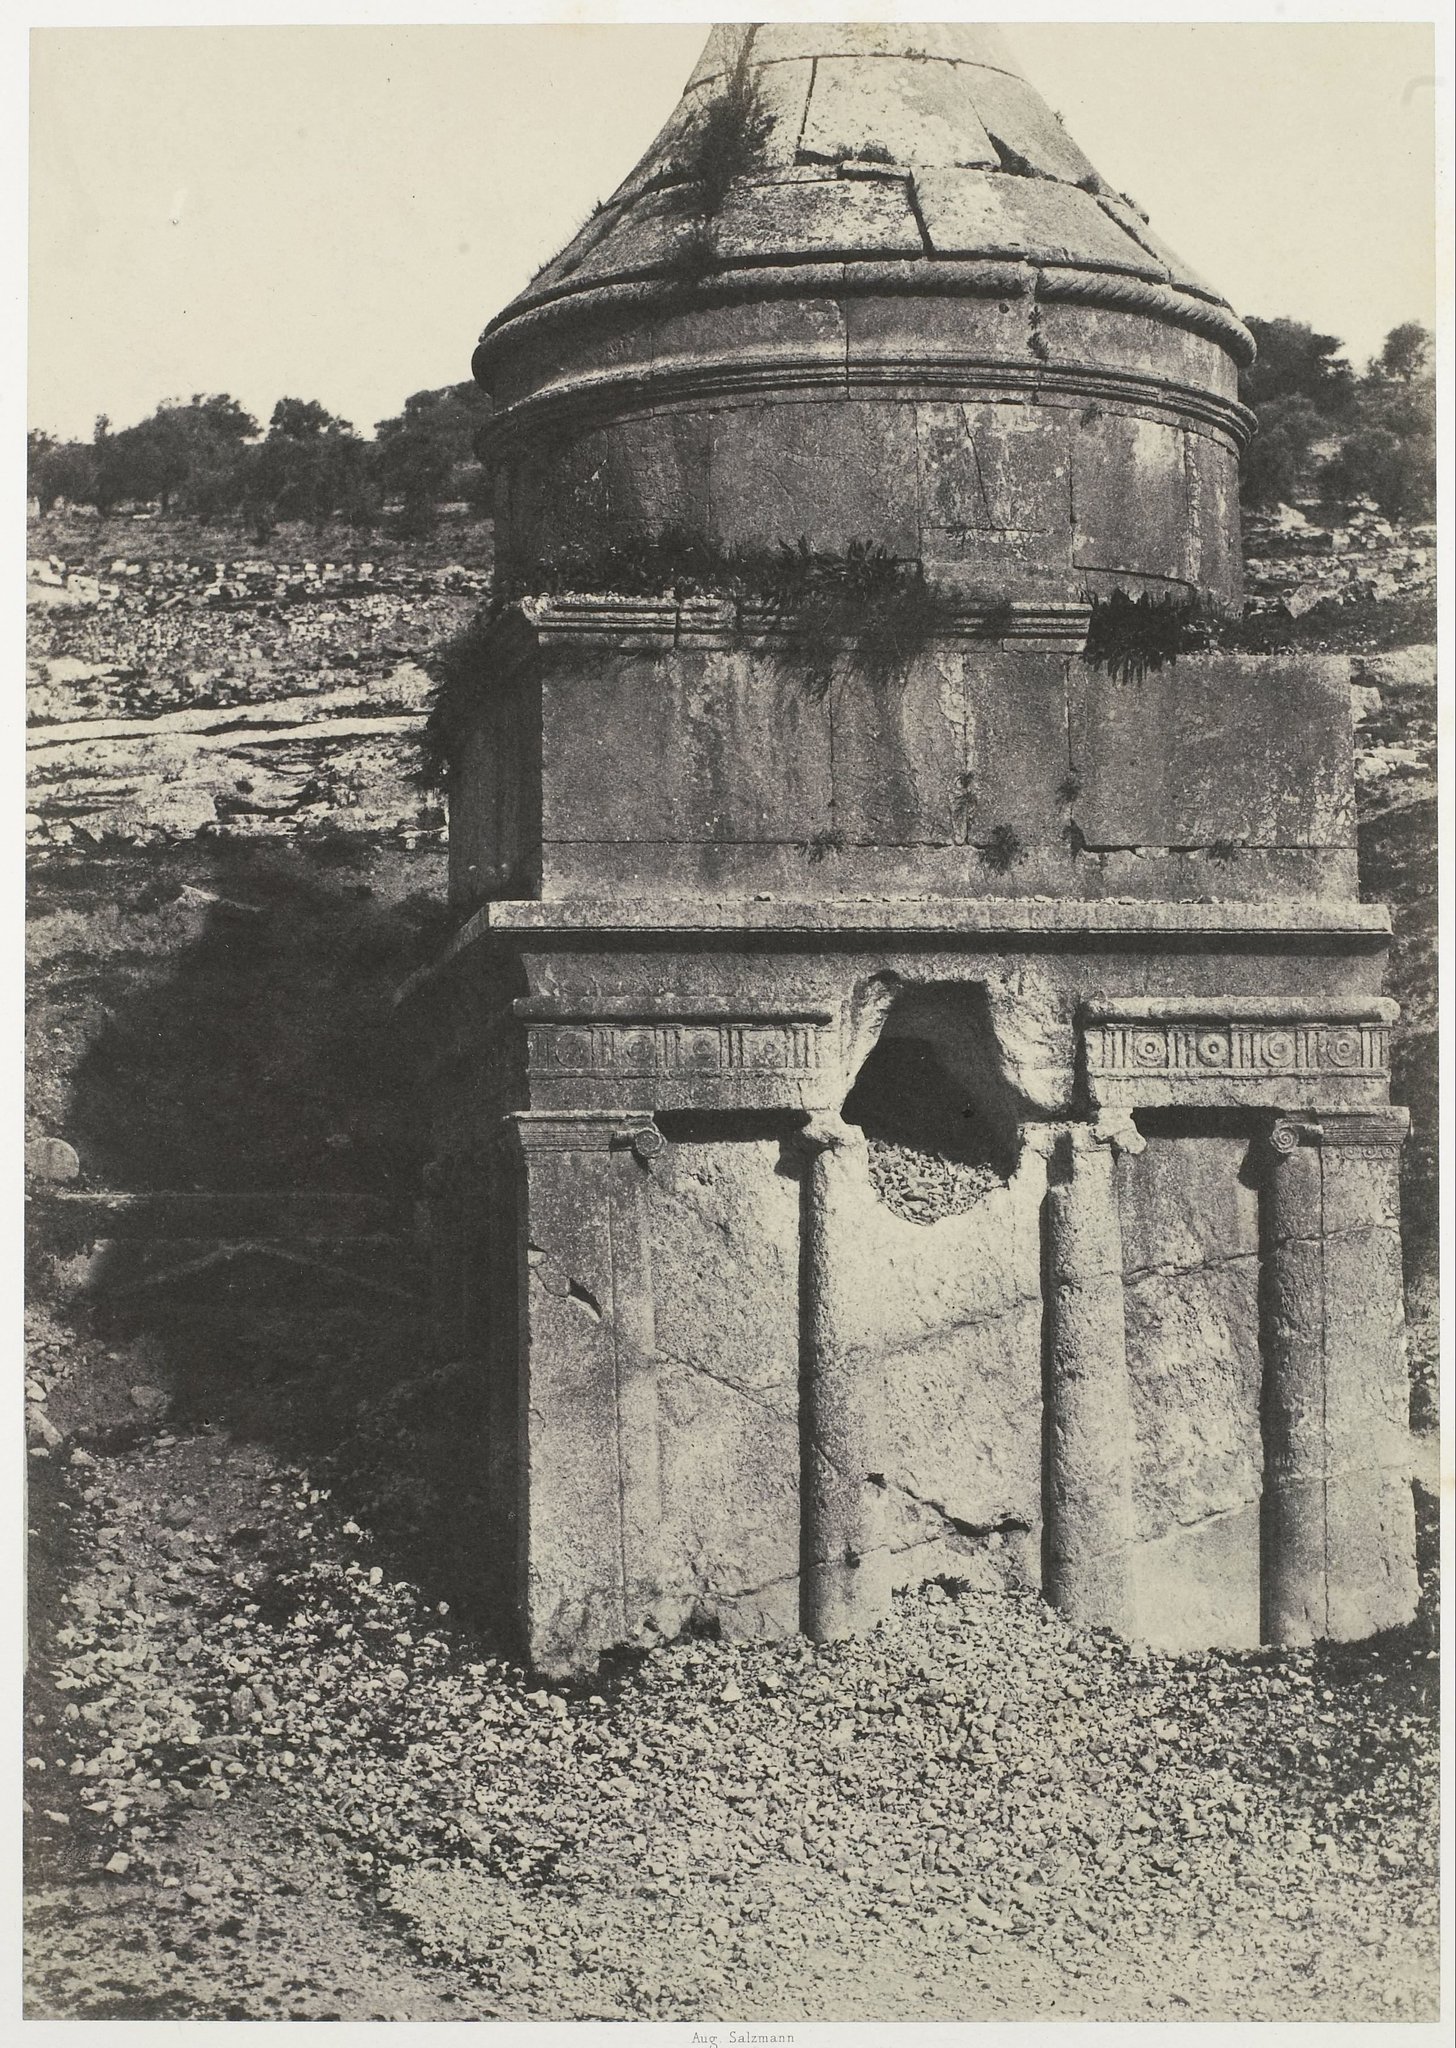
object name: photograph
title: Graftombe van Absalom in Dal van Josafat te Jeruzalem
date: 1854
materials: cardboard, photographic support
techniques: salted paper print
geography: france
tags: grave-building, monumental tomb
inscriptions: date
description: plaat uit boek Auguste Salzmann, Jérusalem. Époques judaïque, romaine, chrétienne, arabe...